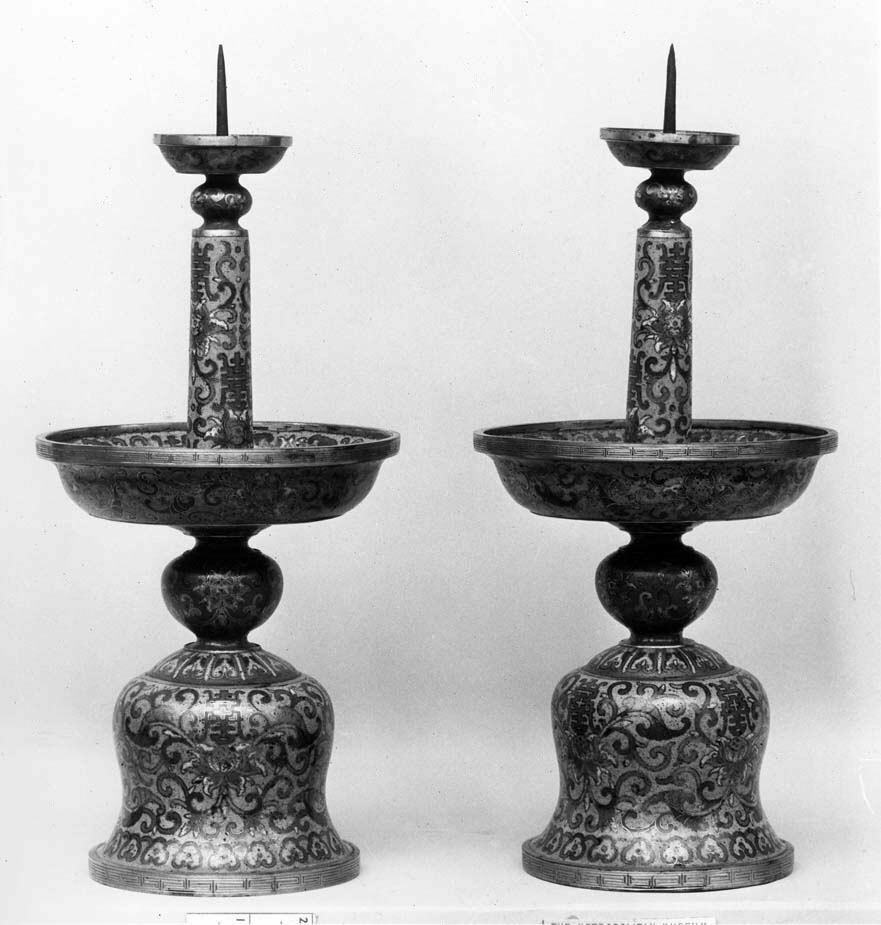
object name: candlestick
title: Candlestick from a Set of Five-Piece Altar Set (Wugong)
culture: chinese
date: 1736-1795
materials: copper, enamel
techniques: enamel